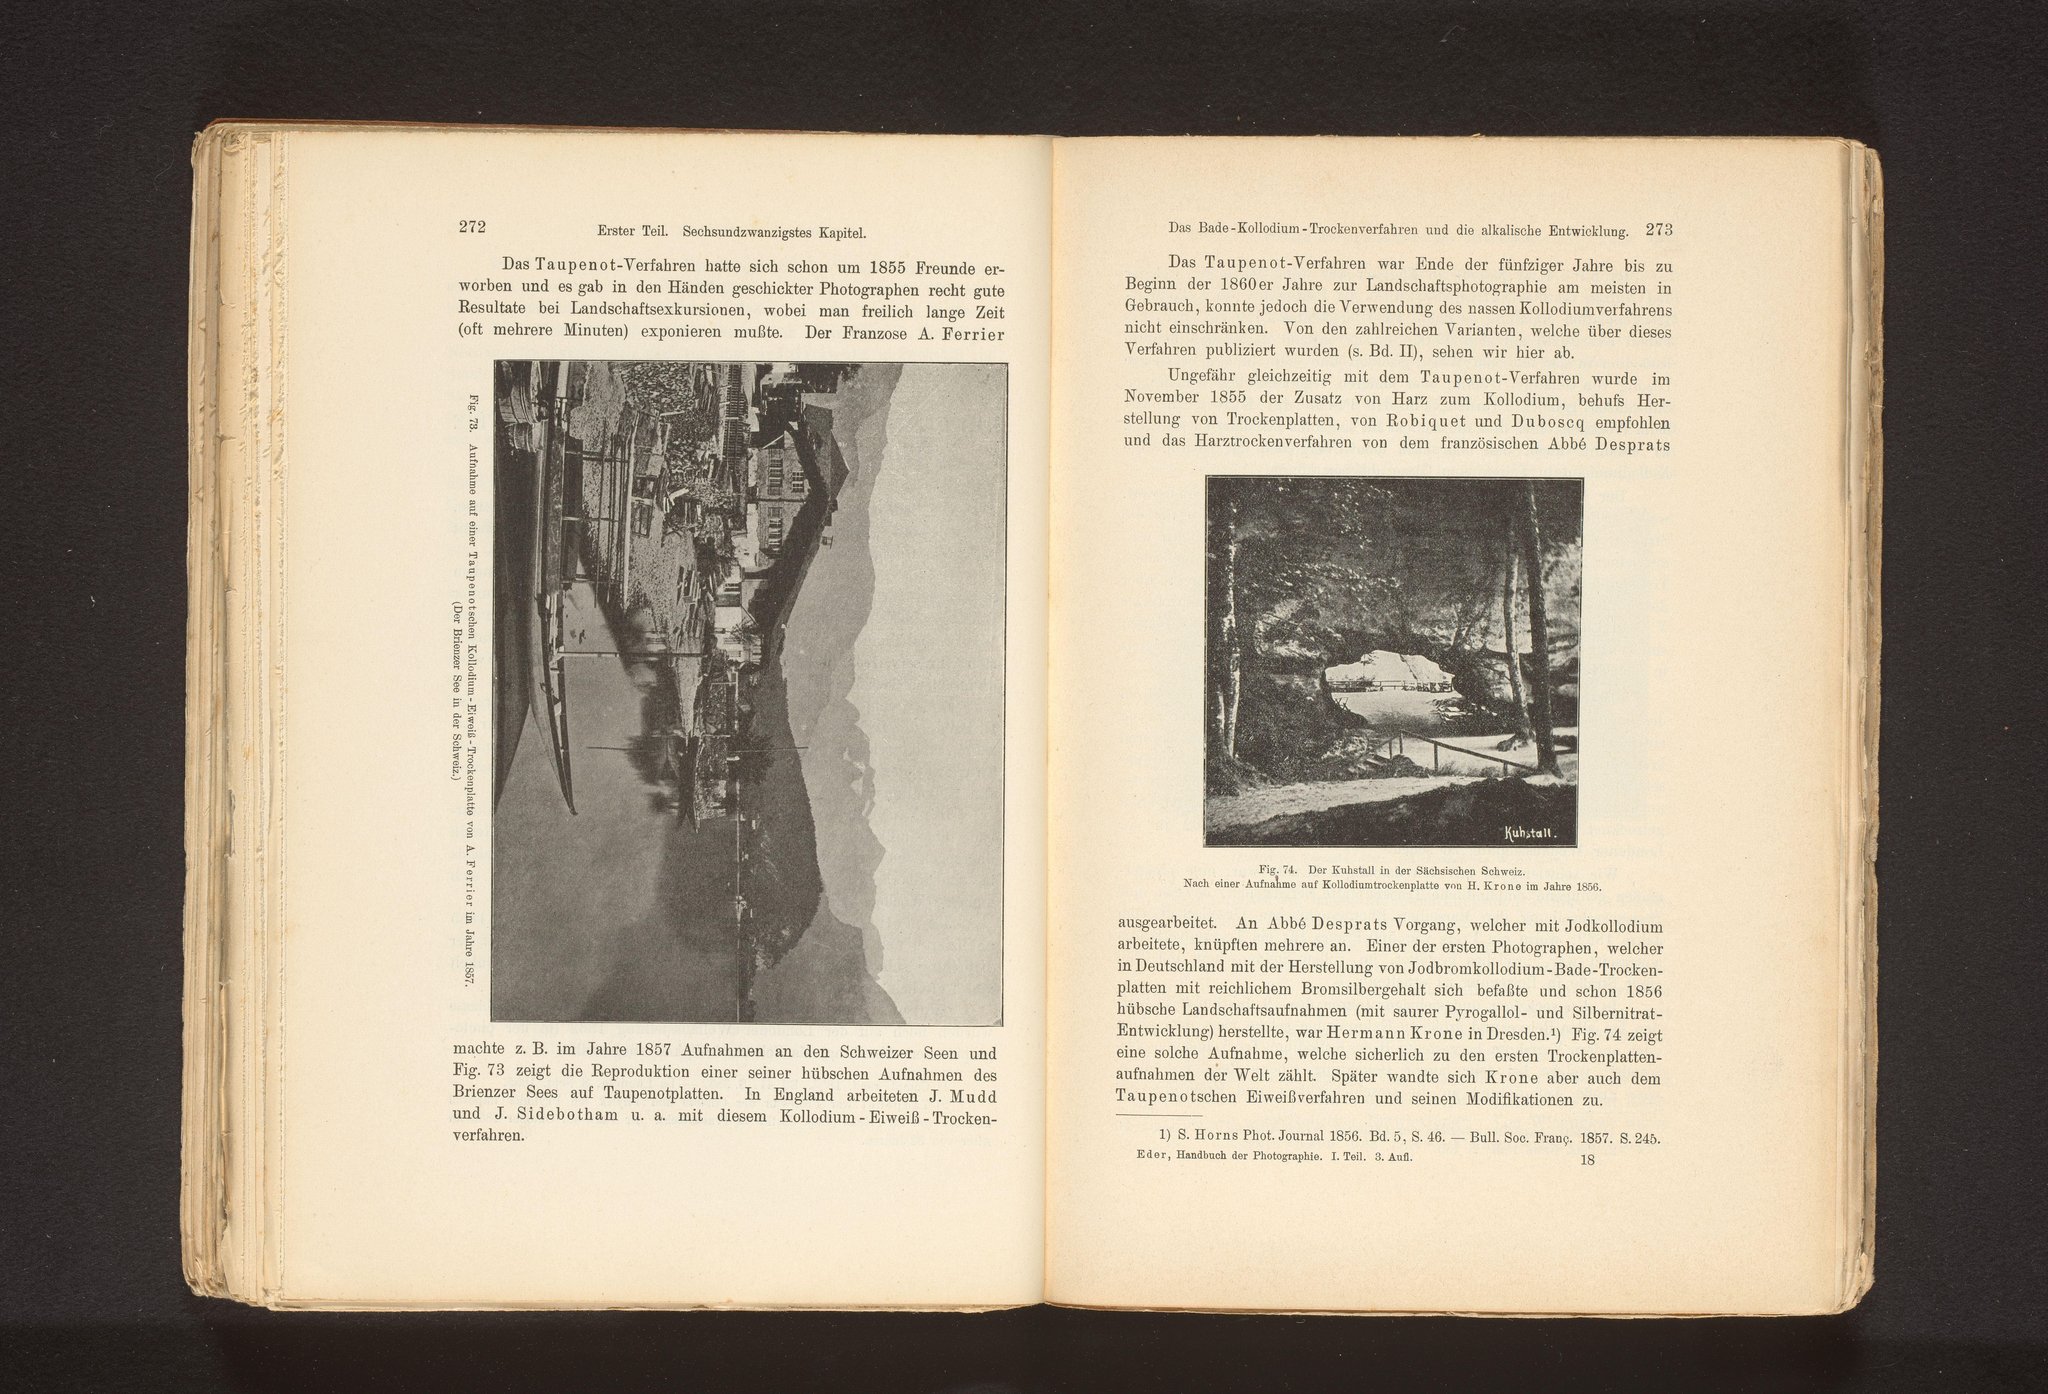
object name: photomechanical print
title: Der Brienzer See in der Schweiz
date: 1900-1905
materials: paper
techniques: autotype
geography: bern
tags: rowing-boat, canoe, etc., lake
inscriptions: number: ‘Fig. 73.’, inscription: ‘Aufnahme auf einer (...) im Jahre 1857.’